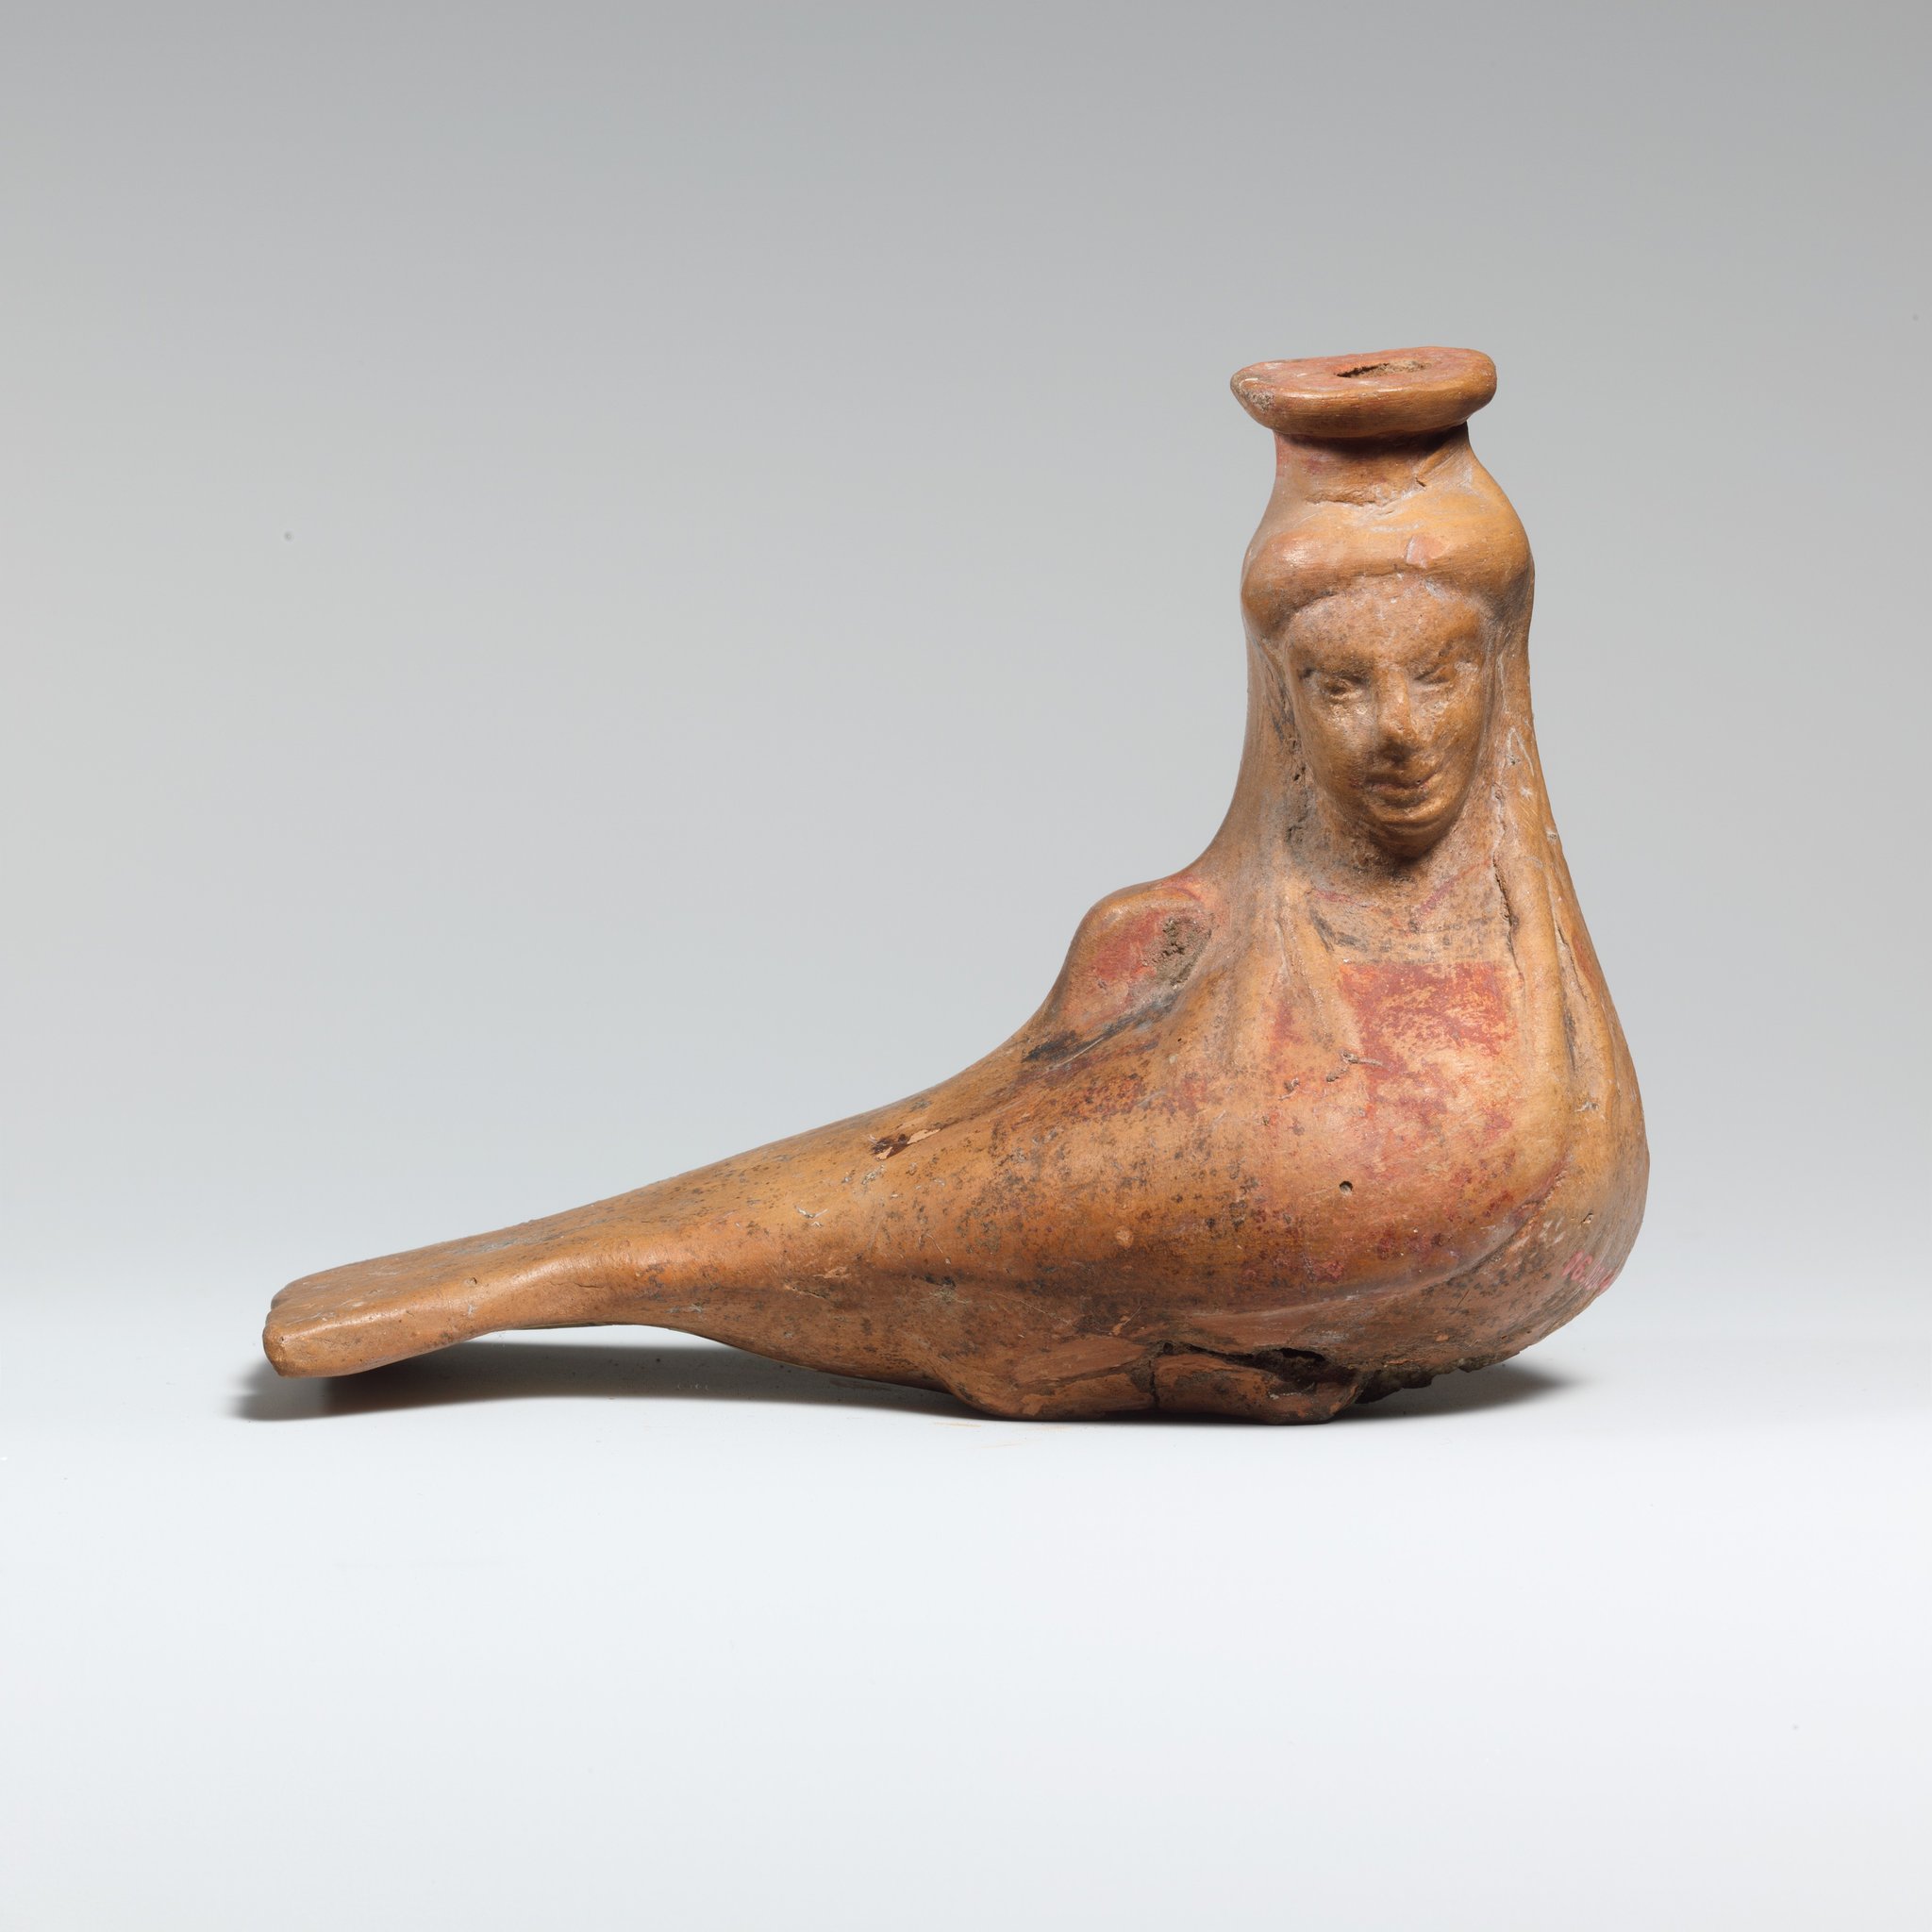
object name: aryballos in the form of a siren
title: Terracotta vase in the form of a siren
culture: east greek, rhodian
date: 550-500 BCE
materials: terracotta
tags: sirens